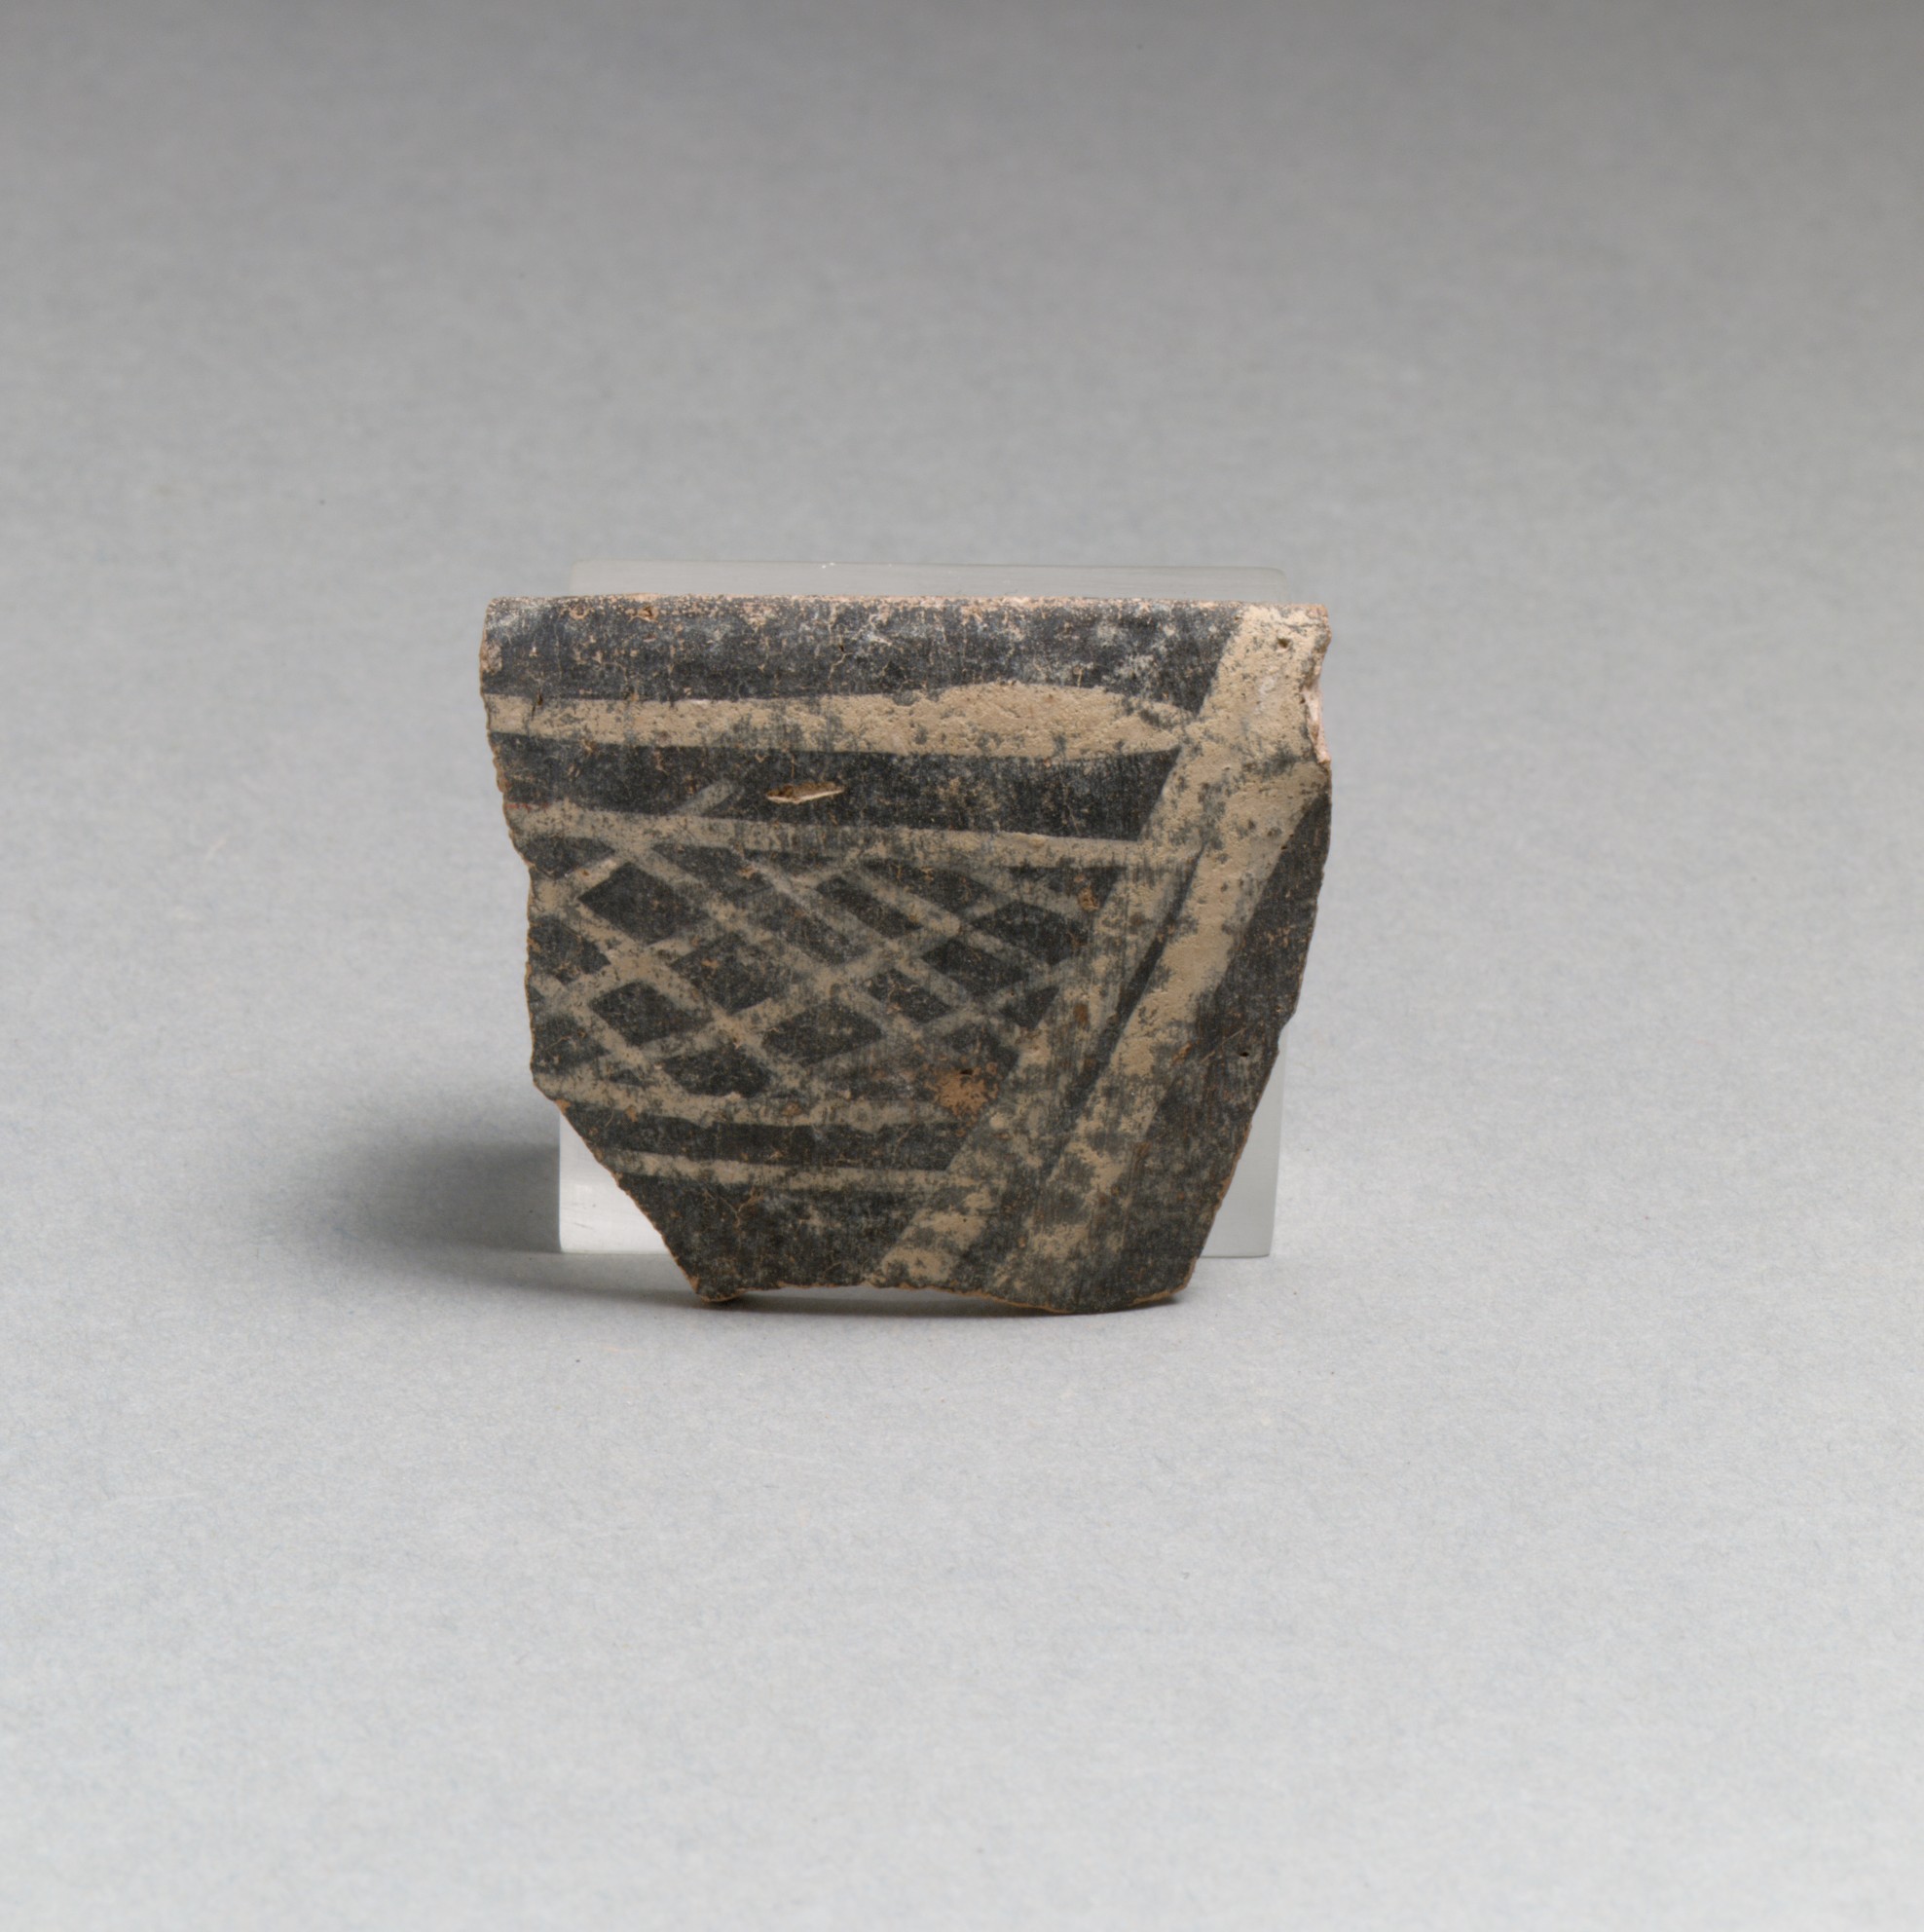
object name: vase fragment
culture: minoan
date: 2600-2000 BCE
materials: terracotta